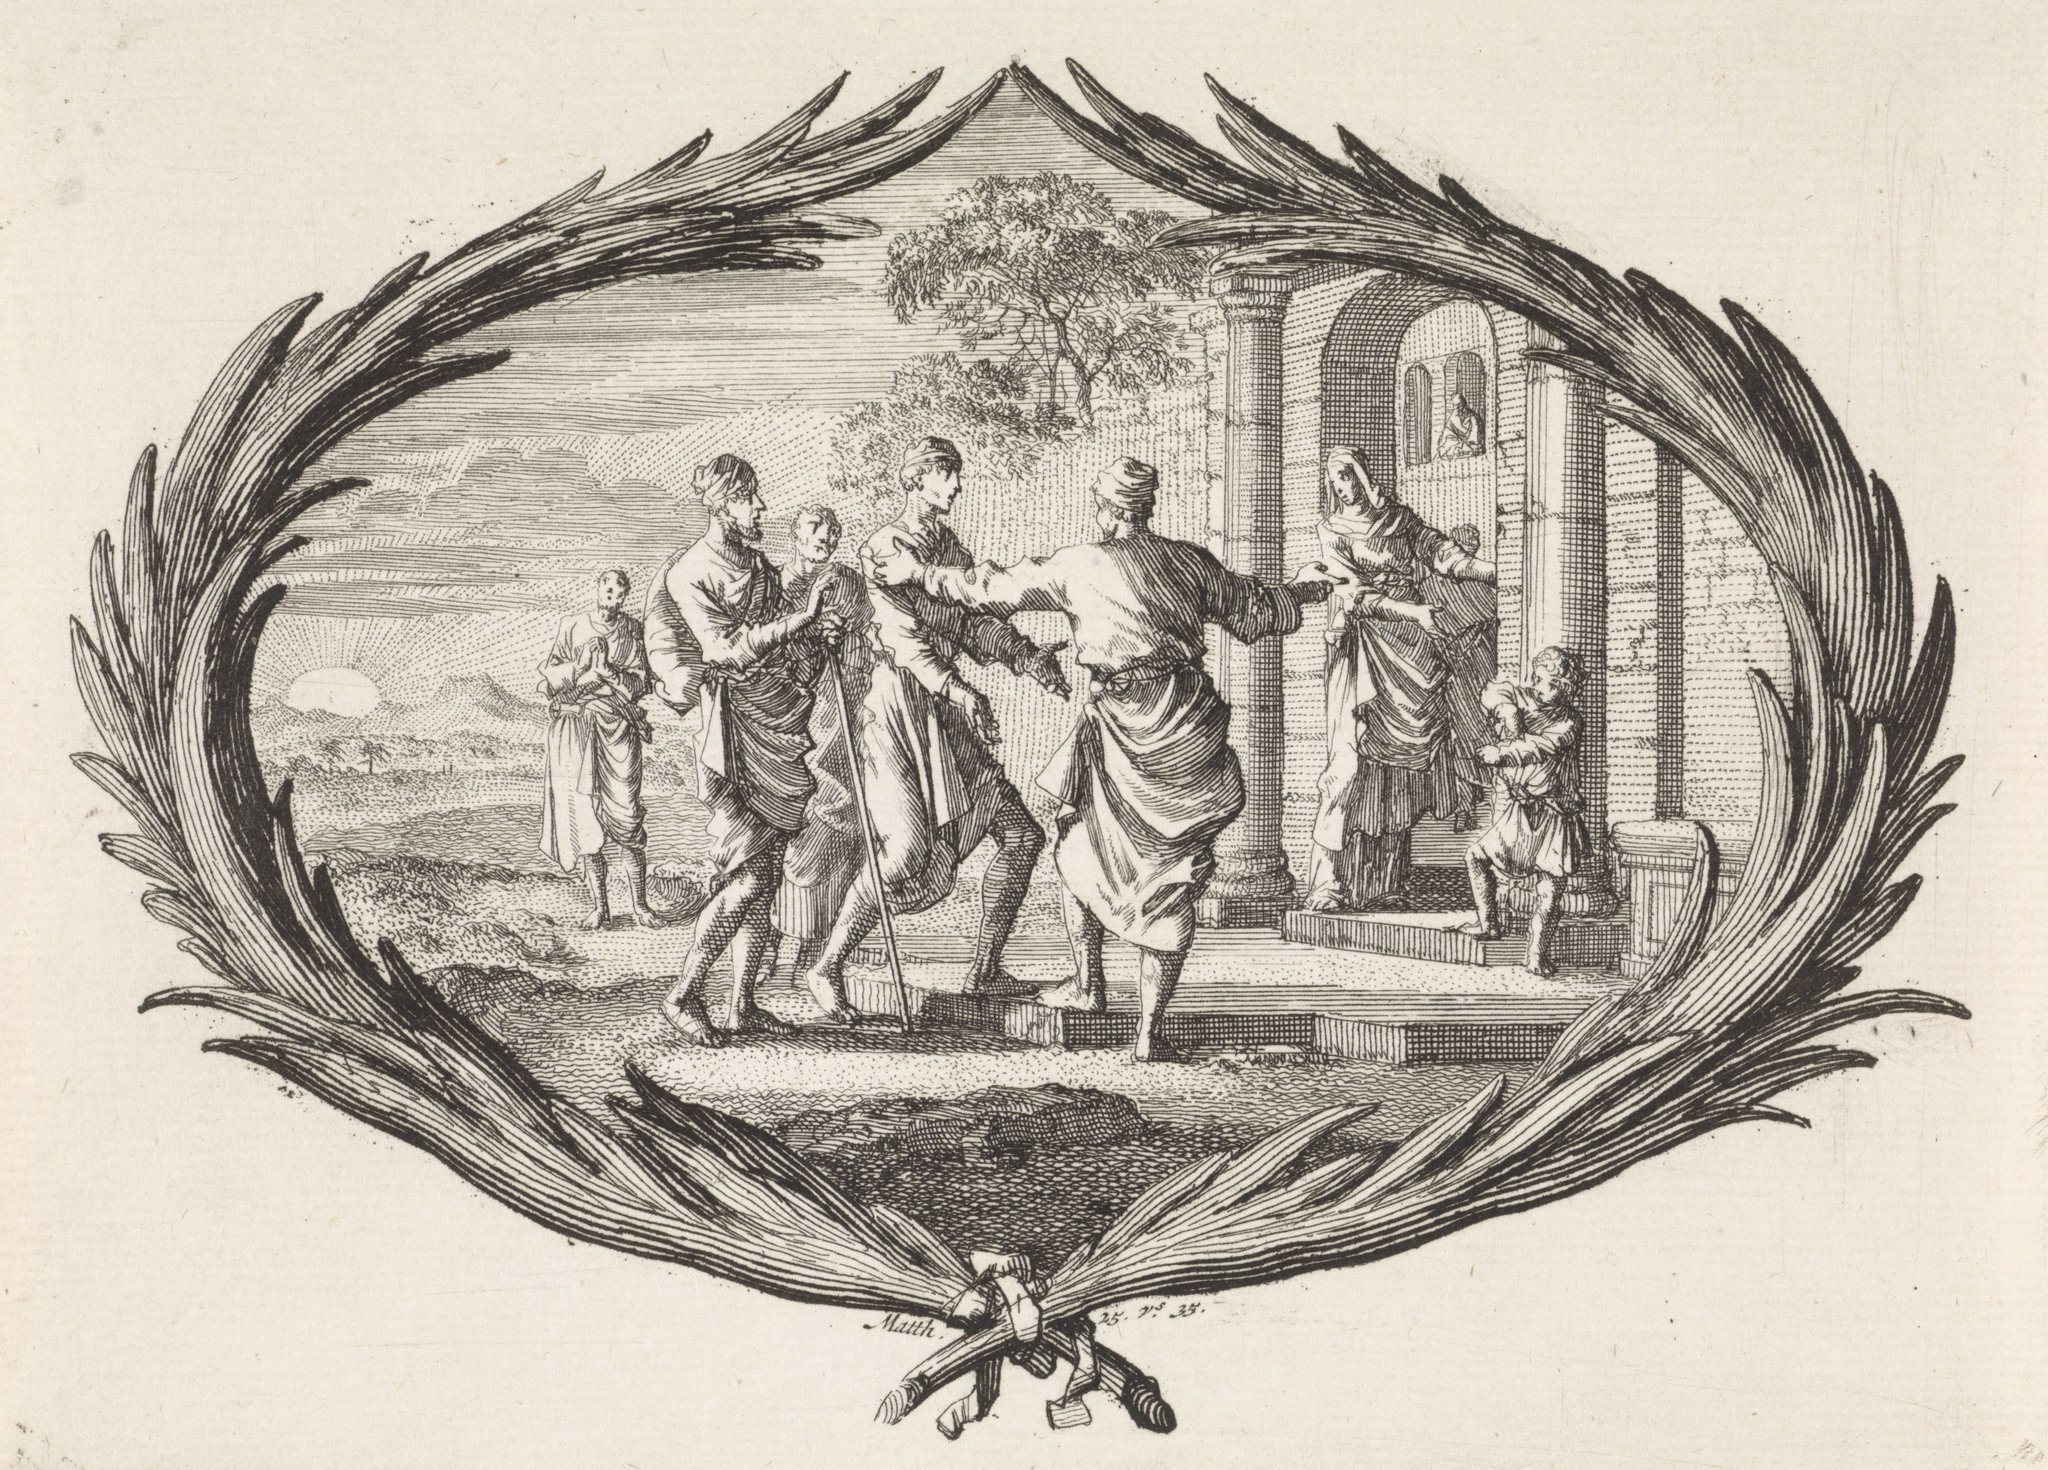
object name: print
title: Vreemdelingen herbergen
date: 1700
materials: paper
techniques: etching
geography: amsterdam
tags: sheltering strangers, 'hospes colligitur' ~ one of the (seven) acts of mercy, being welcomed ~ travelling, ornament ~ cartouche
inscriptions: collector's mark: Lugt 2228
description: Waarschijnlijk boekillustratie voor David Martin. Historie des Ouden en Nieuwen Testaments, verrykt met meer dan vierhonderd printverbeeldingen. Deel II. Amsterdam: Pieter Mortier, 1700, p. 40.